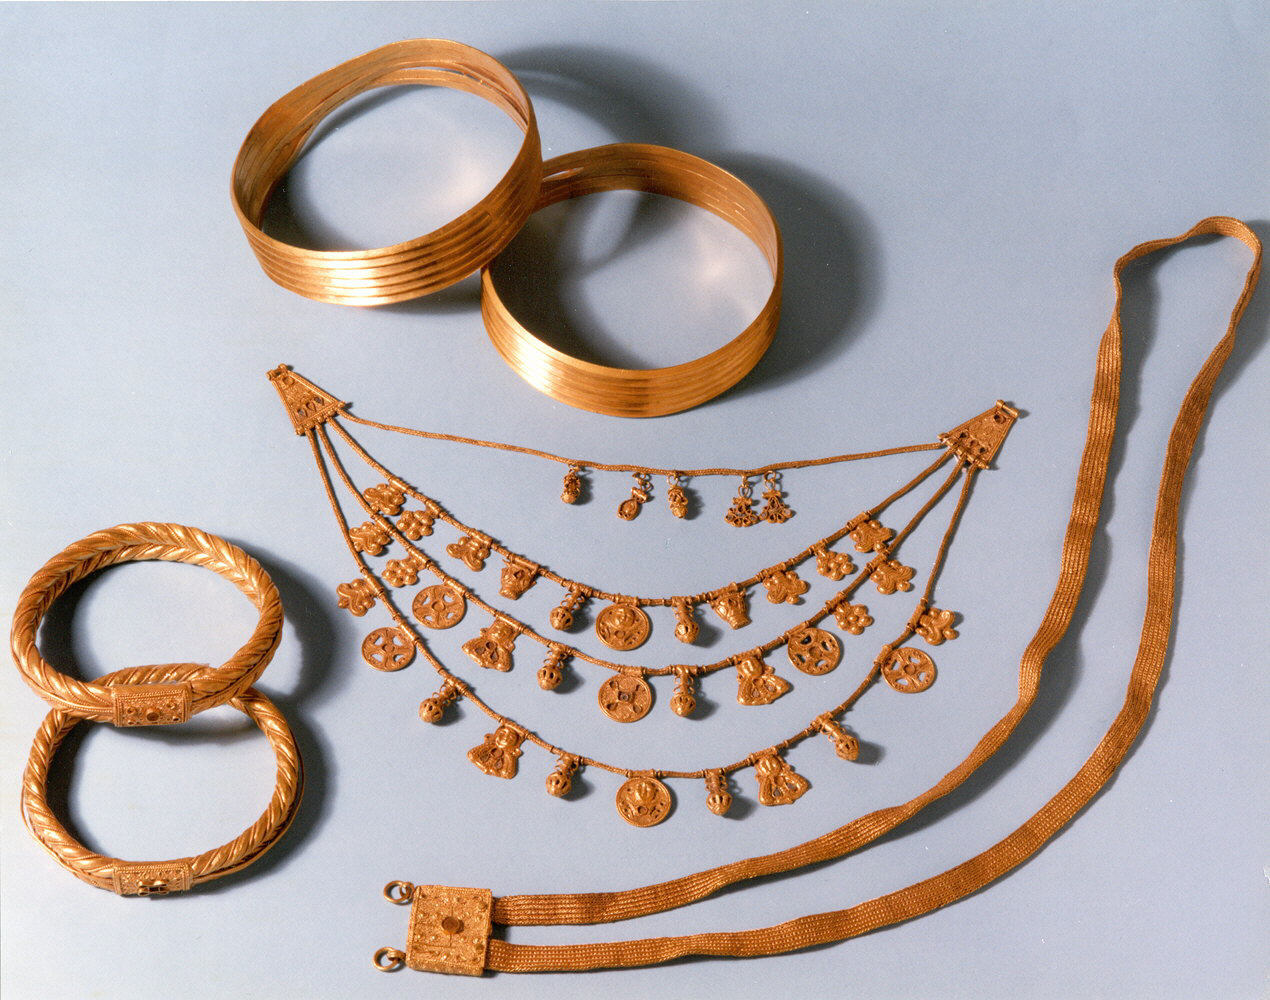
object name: necklace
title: Necklace with pendants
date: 500-301 BCE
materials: enamel, gold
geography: iberian peninsula